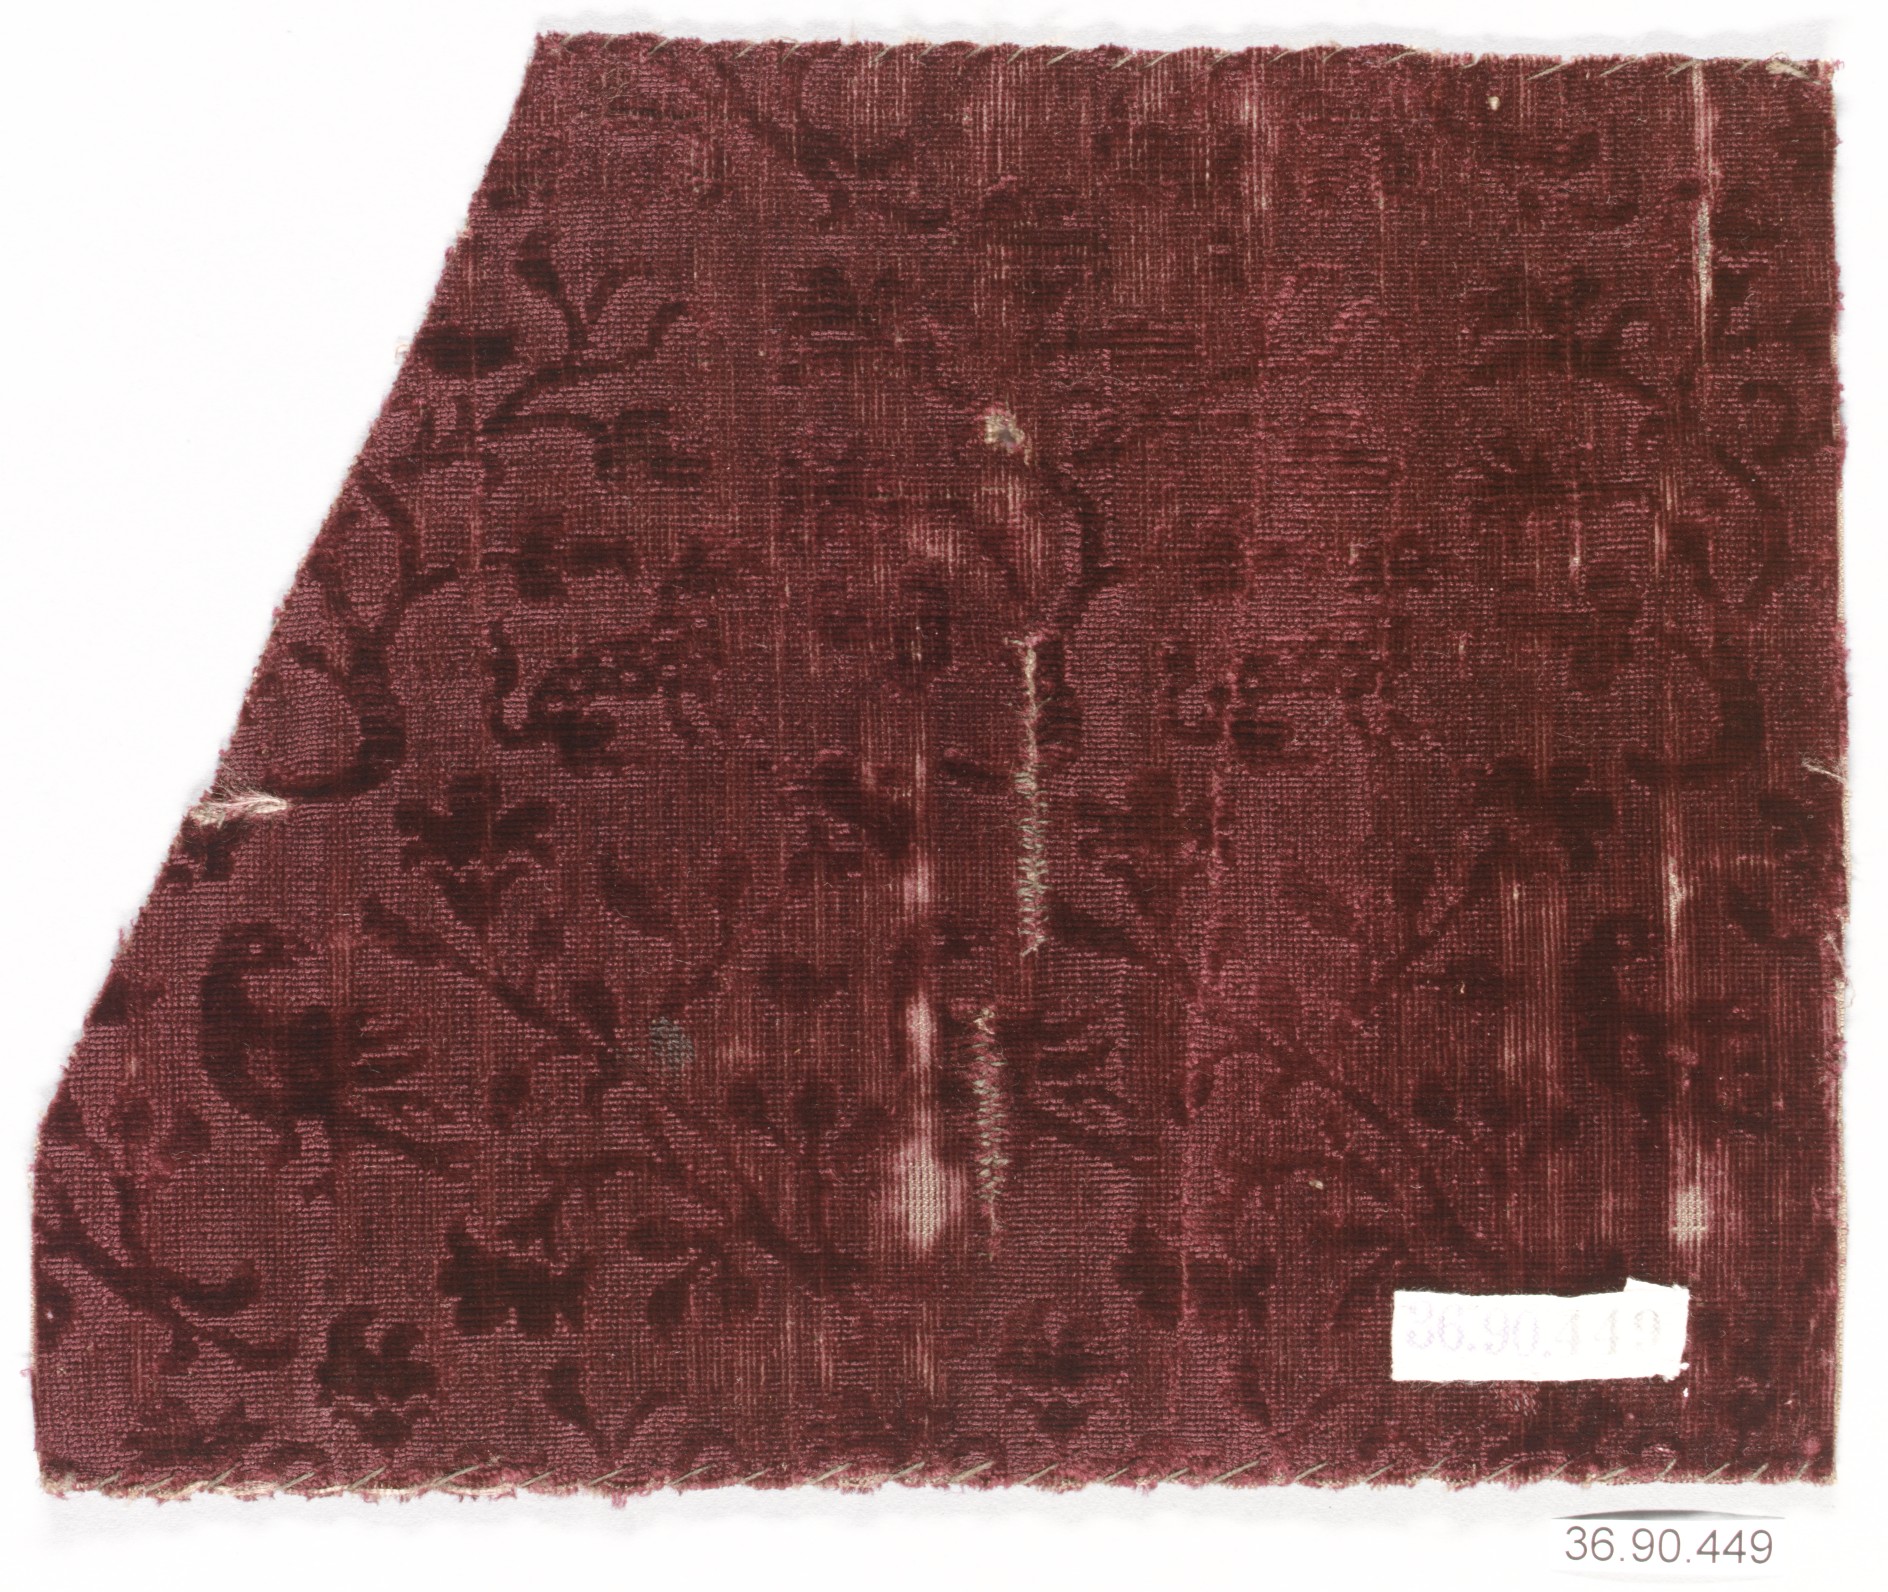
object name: piece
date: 1501-1700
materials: silk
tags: animals,birds